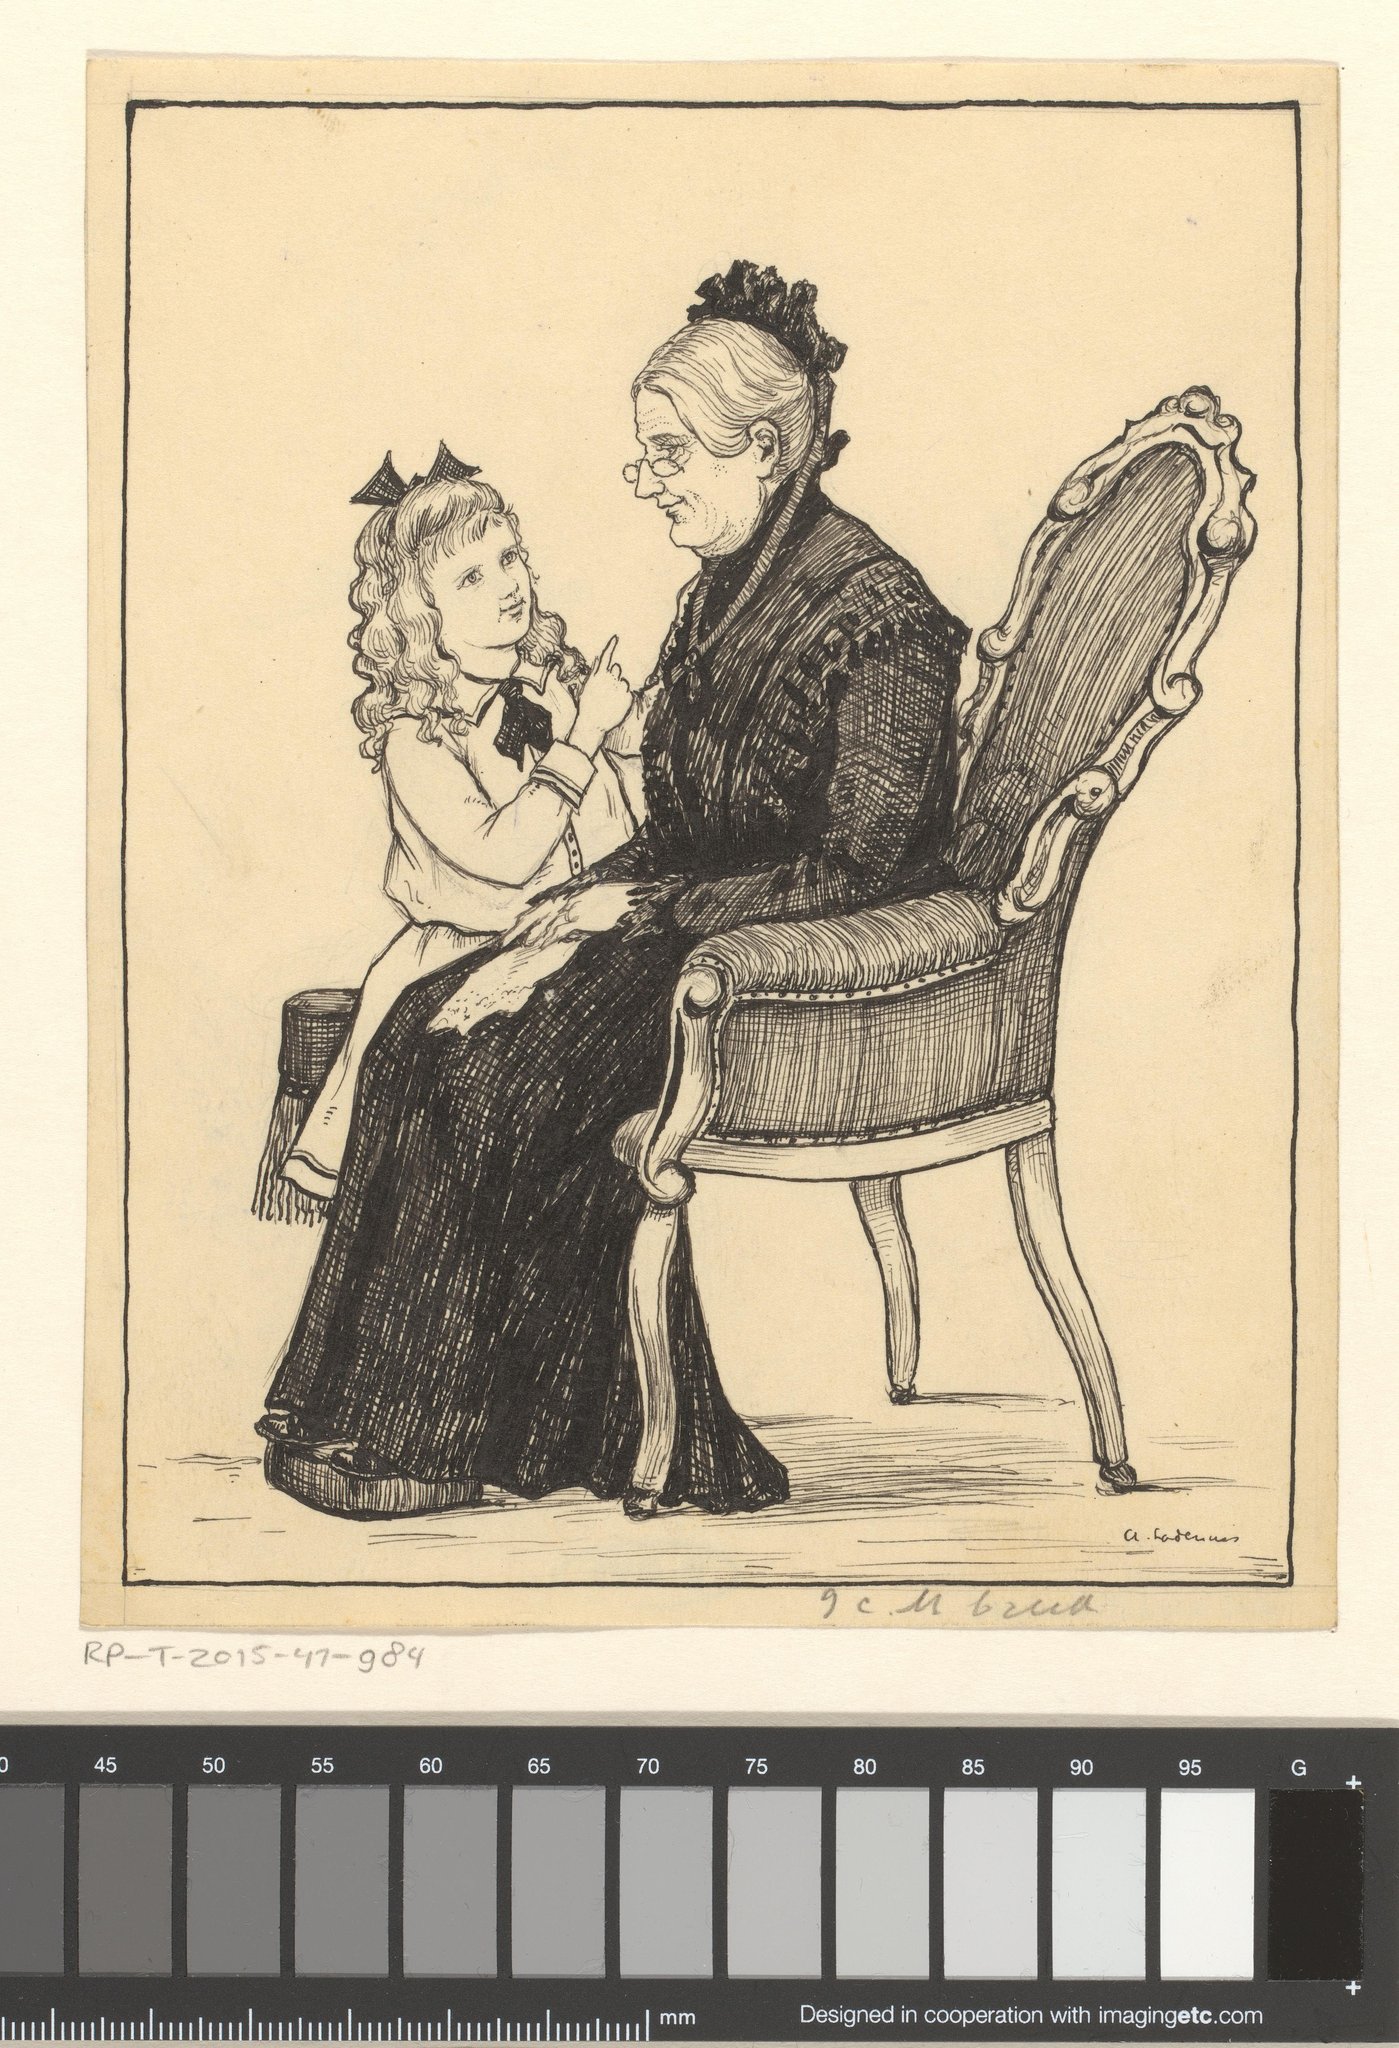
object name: drawing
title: Meisje bij een oude vrouw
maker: adri ladenius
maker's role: draughtsman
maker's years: 1883-1953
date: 1893-1953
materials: ink, paper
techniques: pen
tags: sitting figure (+ old female (human being)), girl (child between toddler and youth), index finger forwards, pointing, indicating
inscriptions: :, annotation: ‘[...]oertje zonder/ naam/ IV’, collector's mark: Lugt 2228, signature: ‘A. Ladenius’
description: Een oude vrouw met een bril zit in een stoel met een zakdoek op schoot. Een meisje staat bij haar stoel en wijst omhoog.